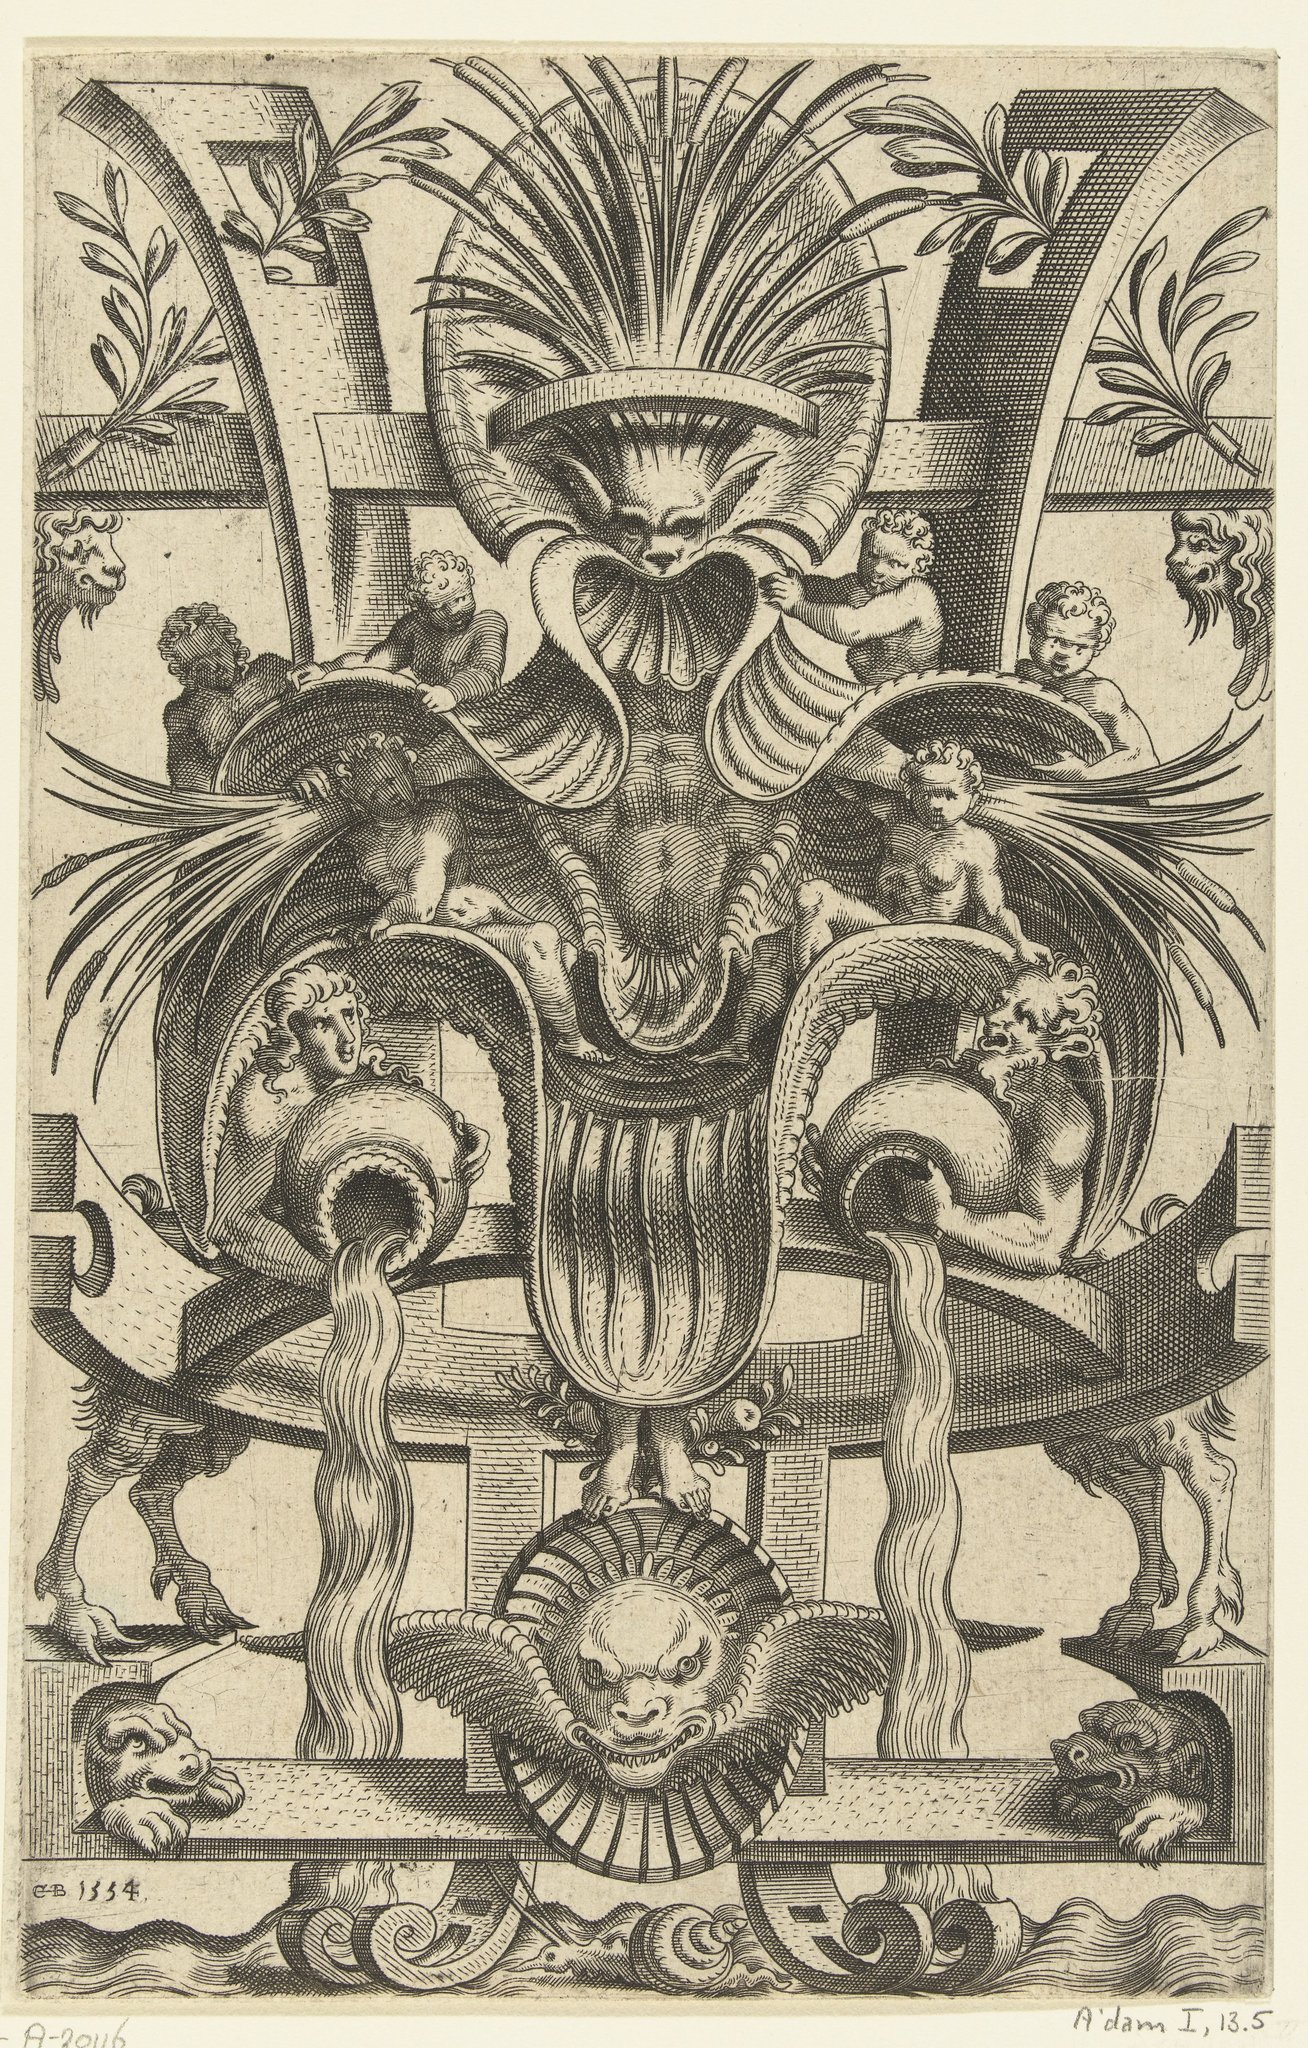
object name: print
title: Grotesk; paneelvulling. In het midden een fantastische figuur in een schelpachtig ornament, waarin en waarop zich zes kinderen bewegen. Daaronder twee saters, die elk een waterkruik uitstorten. In den l.o. CB 1554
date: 1554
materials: paper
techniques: engraving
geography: netherlands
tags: ornament ~ grotesque, scrollwork, strapwork ~ ornament, scallop, shell ~ ornament, satyr(s) (in general)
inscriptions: date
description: Rolwerk met een gemaskerde figuur in een schelpachtige omhulling, en zes kindertjes. Links en rechts een sater die een kruik draagt. Blad uit serie van 6 bladen met groteske vlakdecoraties met rolwerk, kandelabers, saters, vruchtenguirlandes, vogels en fantasiewezens.